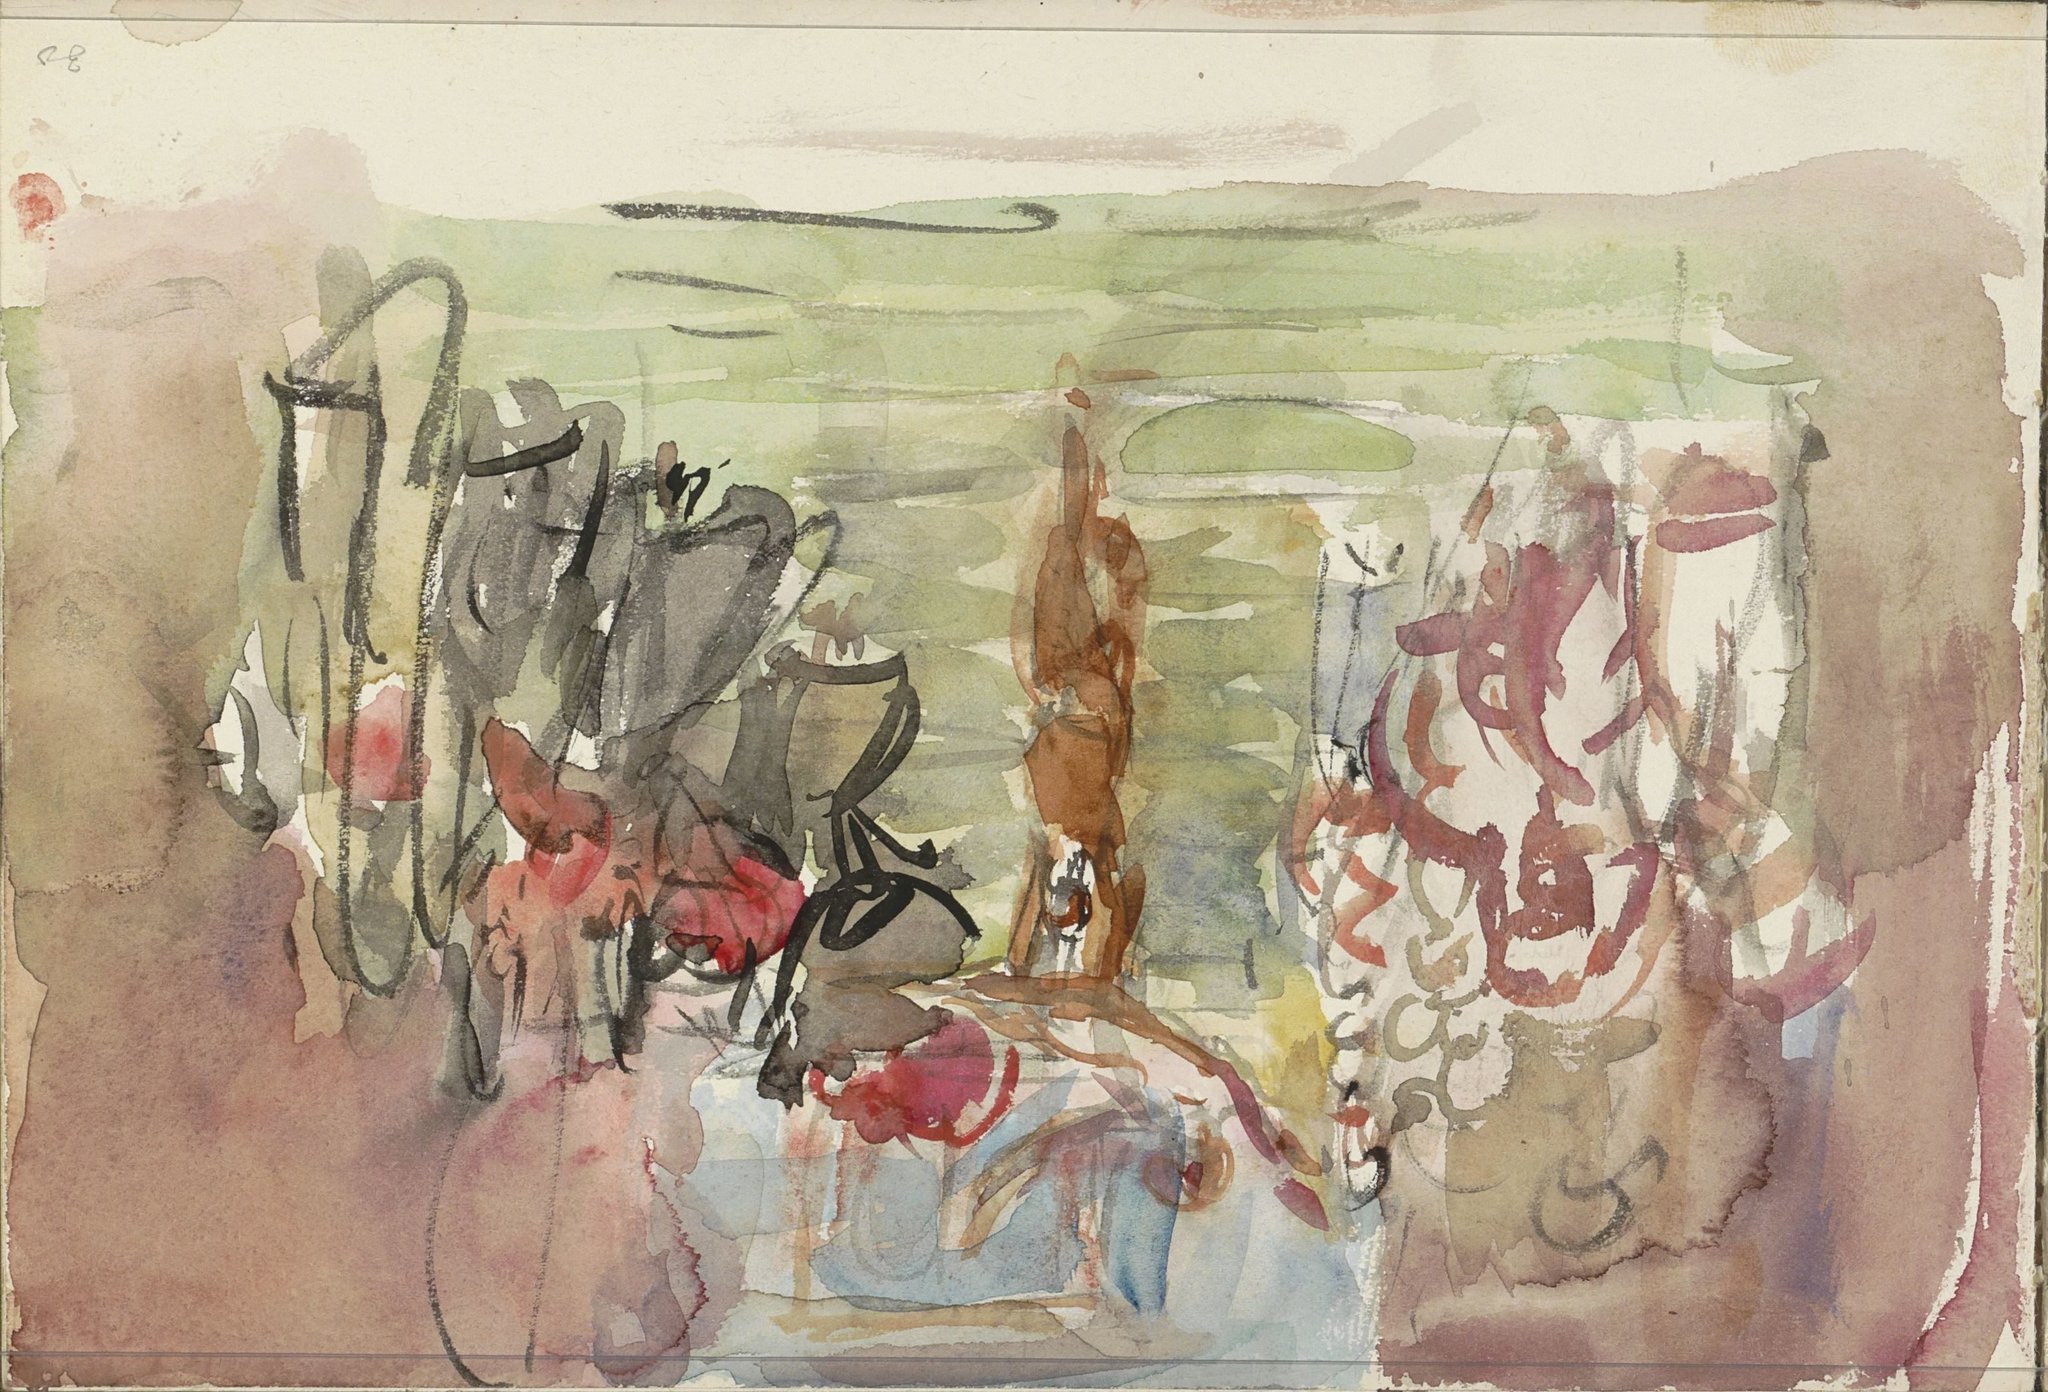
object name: sketchbook leaf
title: Artiesten op het toneel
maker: isaac israels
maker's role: draughtsman, painter, print maker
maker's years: 1865-1934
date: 1875-1934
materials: paper, watercolor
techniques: brush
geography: the hague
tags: theatre, theatrical performance, the stage and its equipment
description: Mogelijk acrobaten of dansers. Blad 5 verso uit schetsboek XXVIII met 17 bladen.